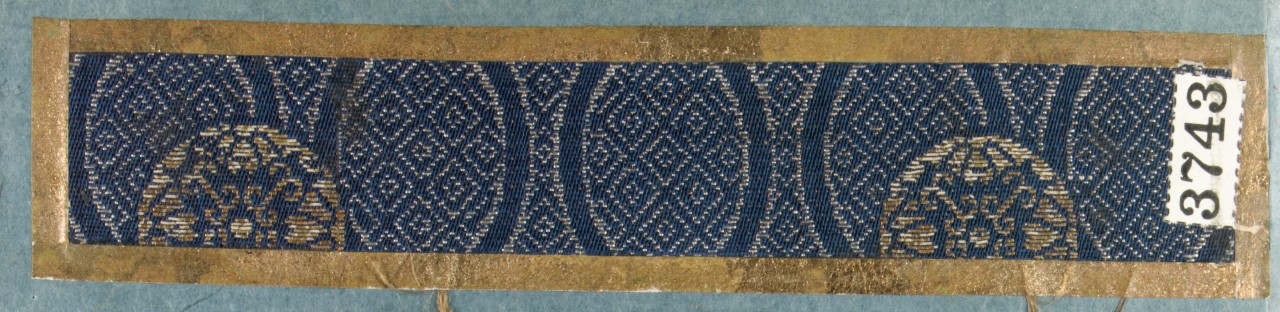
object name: sample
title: Textile Sample from Sample Book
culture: japanese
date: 1801-1900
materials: silk